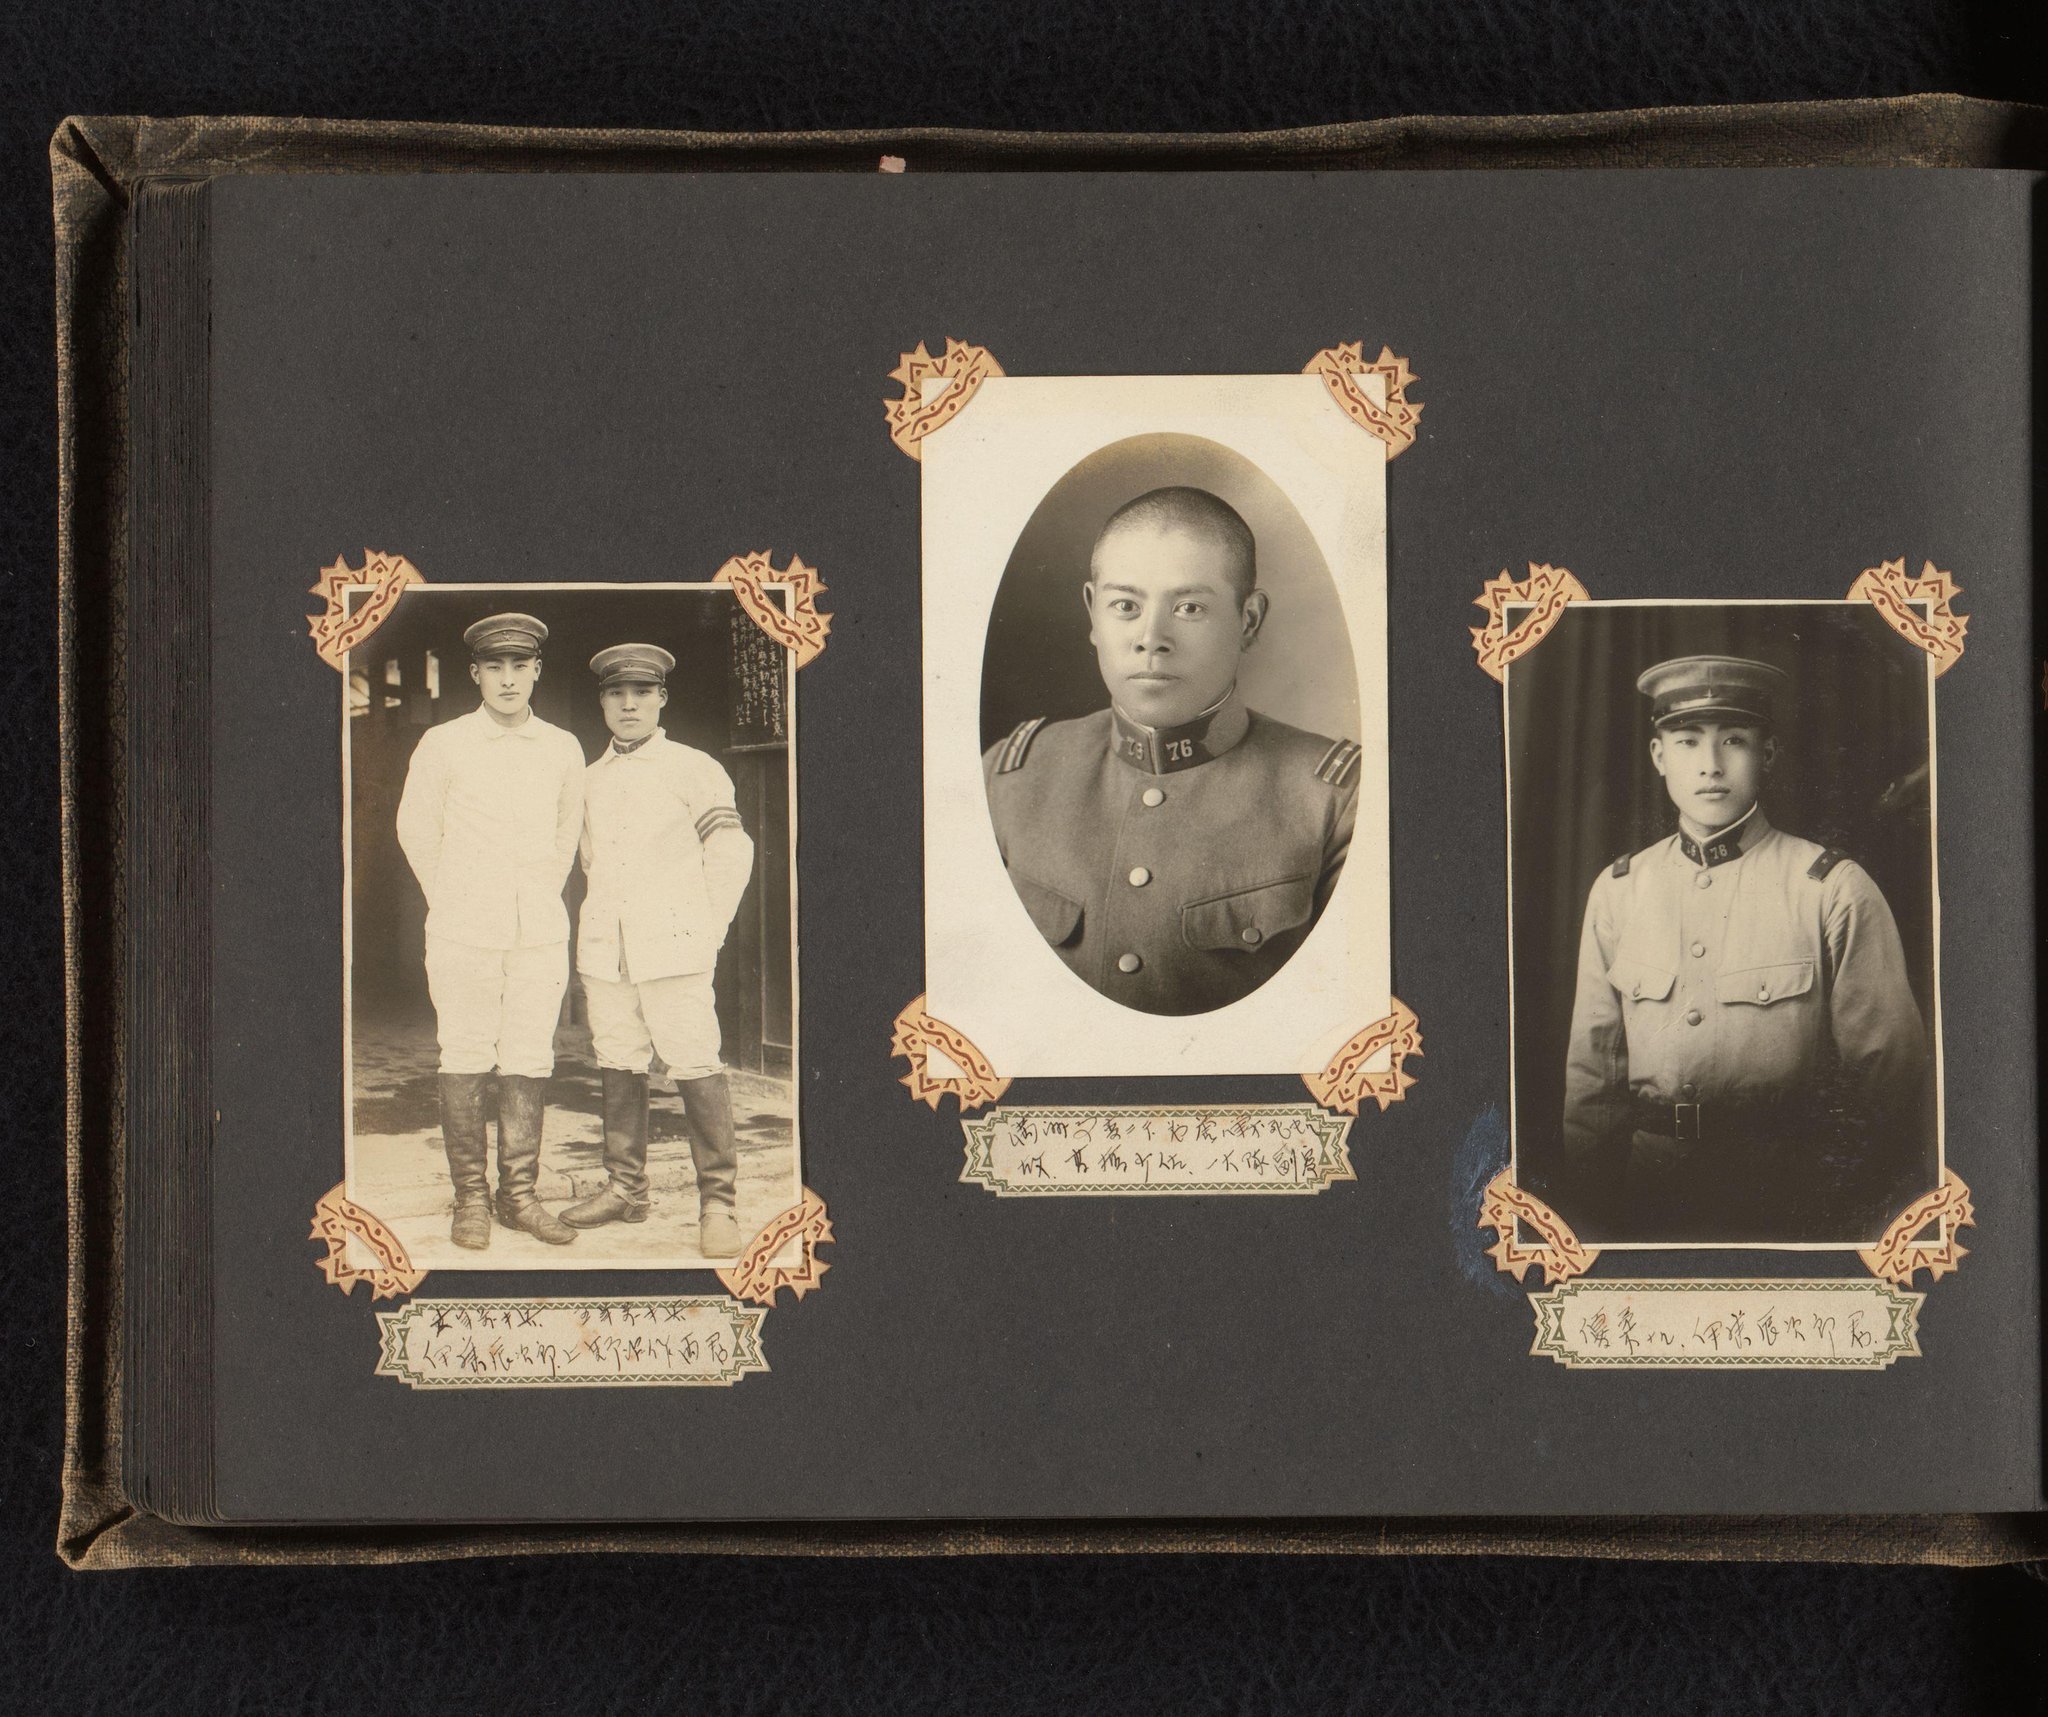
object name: album leaf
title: Drie portretten van onbekende Japanse soldaten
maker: Anonymous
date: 1930-1940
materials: paper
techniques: gelatin silver print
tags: anonymous historical person portrayed, the soldier; the soldier's life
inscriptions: inscription: ‘[...]’